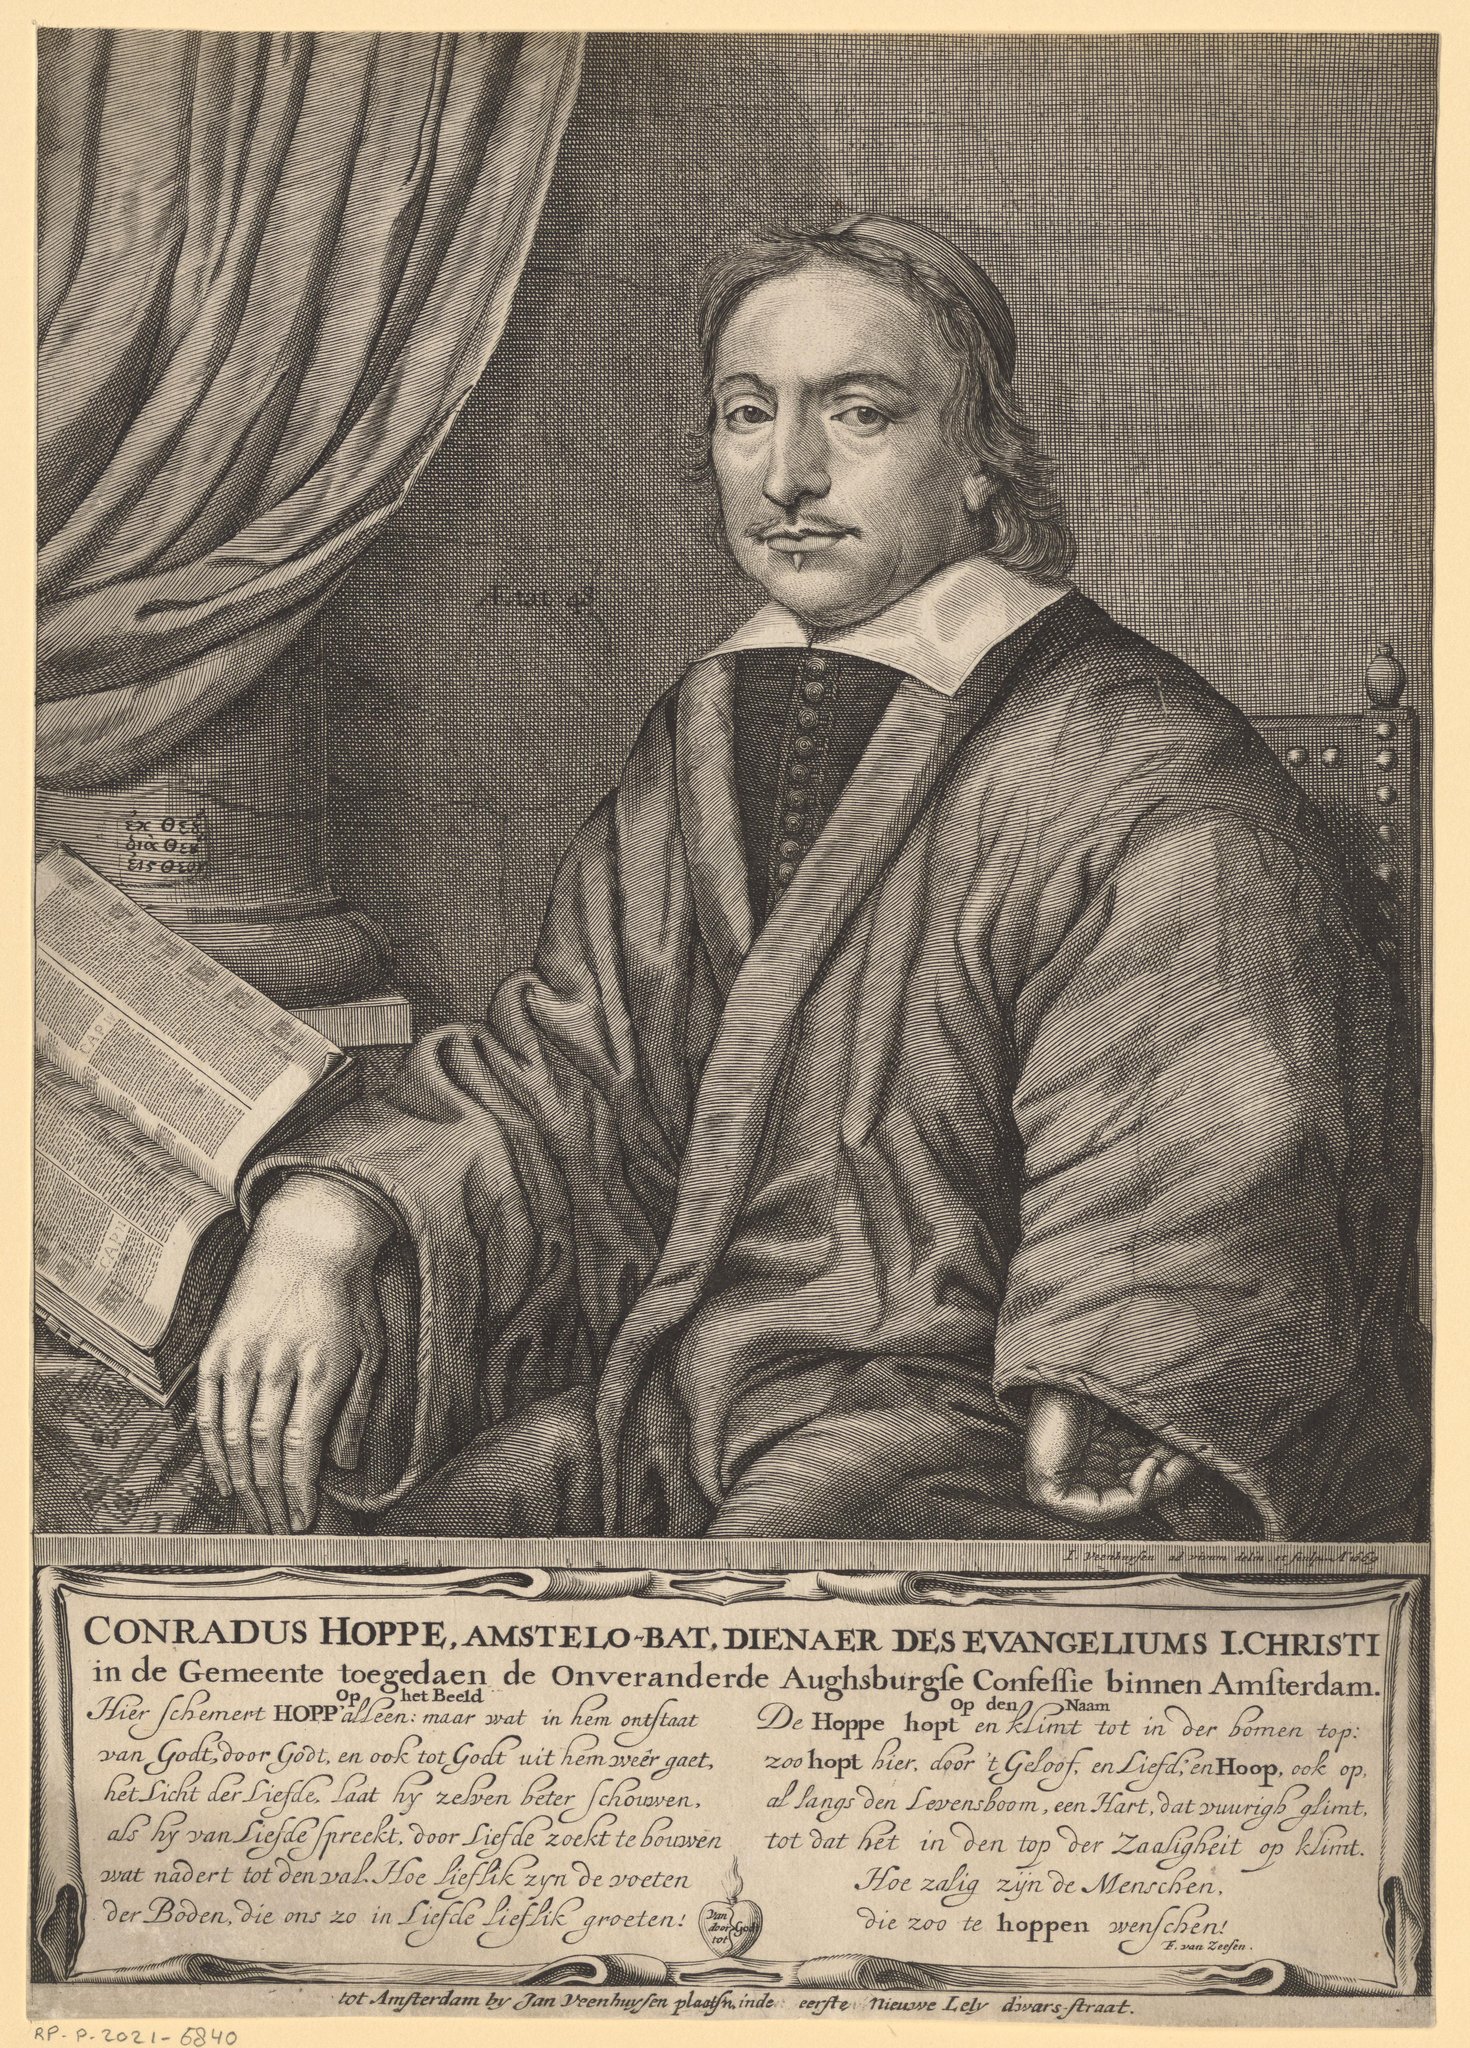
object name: print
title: Portret van Conradus Hoppe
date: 1669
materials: paper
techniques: engraving, etching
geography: amsterdam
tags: historical persons, functionaries and dignitaries ~ episcopal protestant churches, book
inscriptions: collector's mark: Lugt 2228